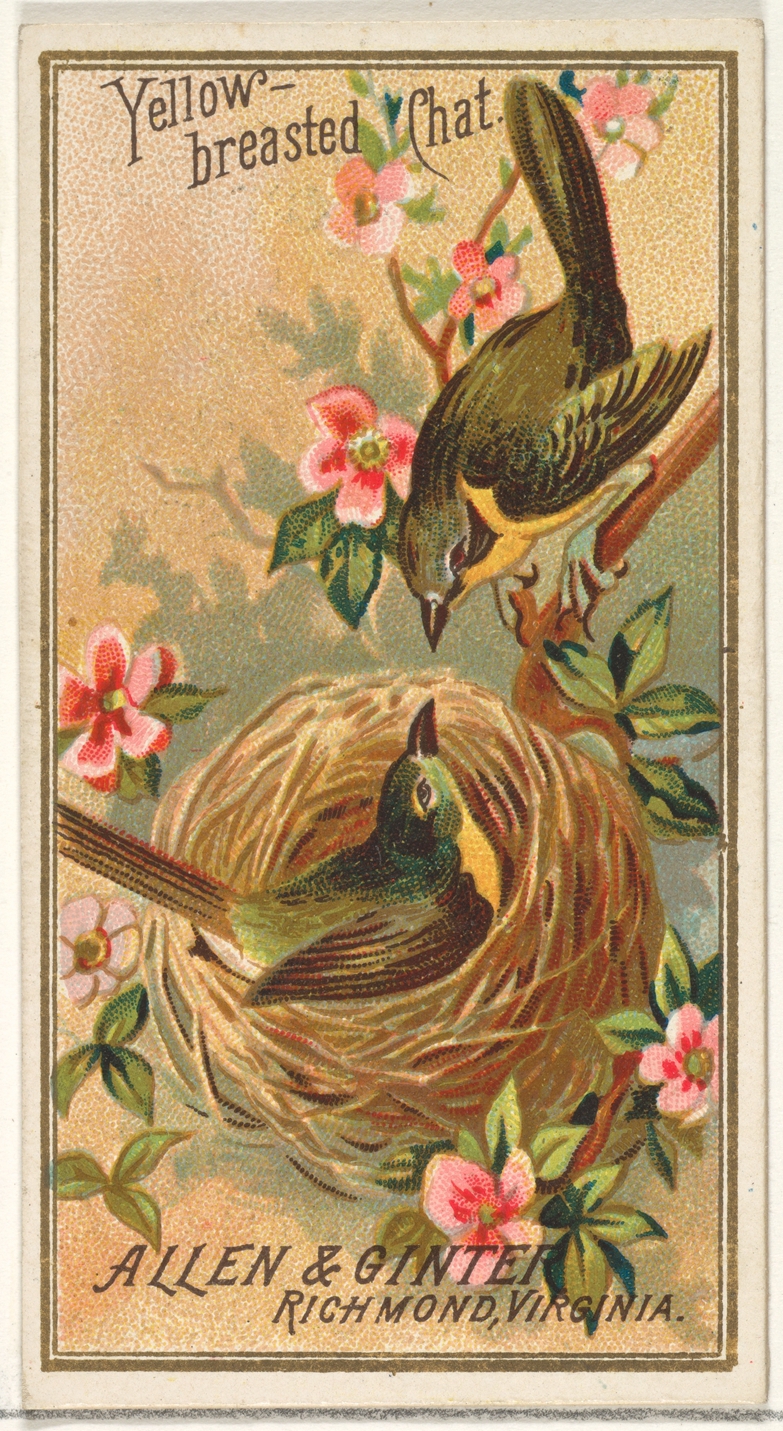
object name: print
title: Yellow-breasted Chat, from the Birds of America series (N4) for Allen & Ginter Cigarettes Brands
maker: allen & ginter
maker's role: publisher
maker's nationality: american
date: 1888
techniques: color lithograph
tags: birds